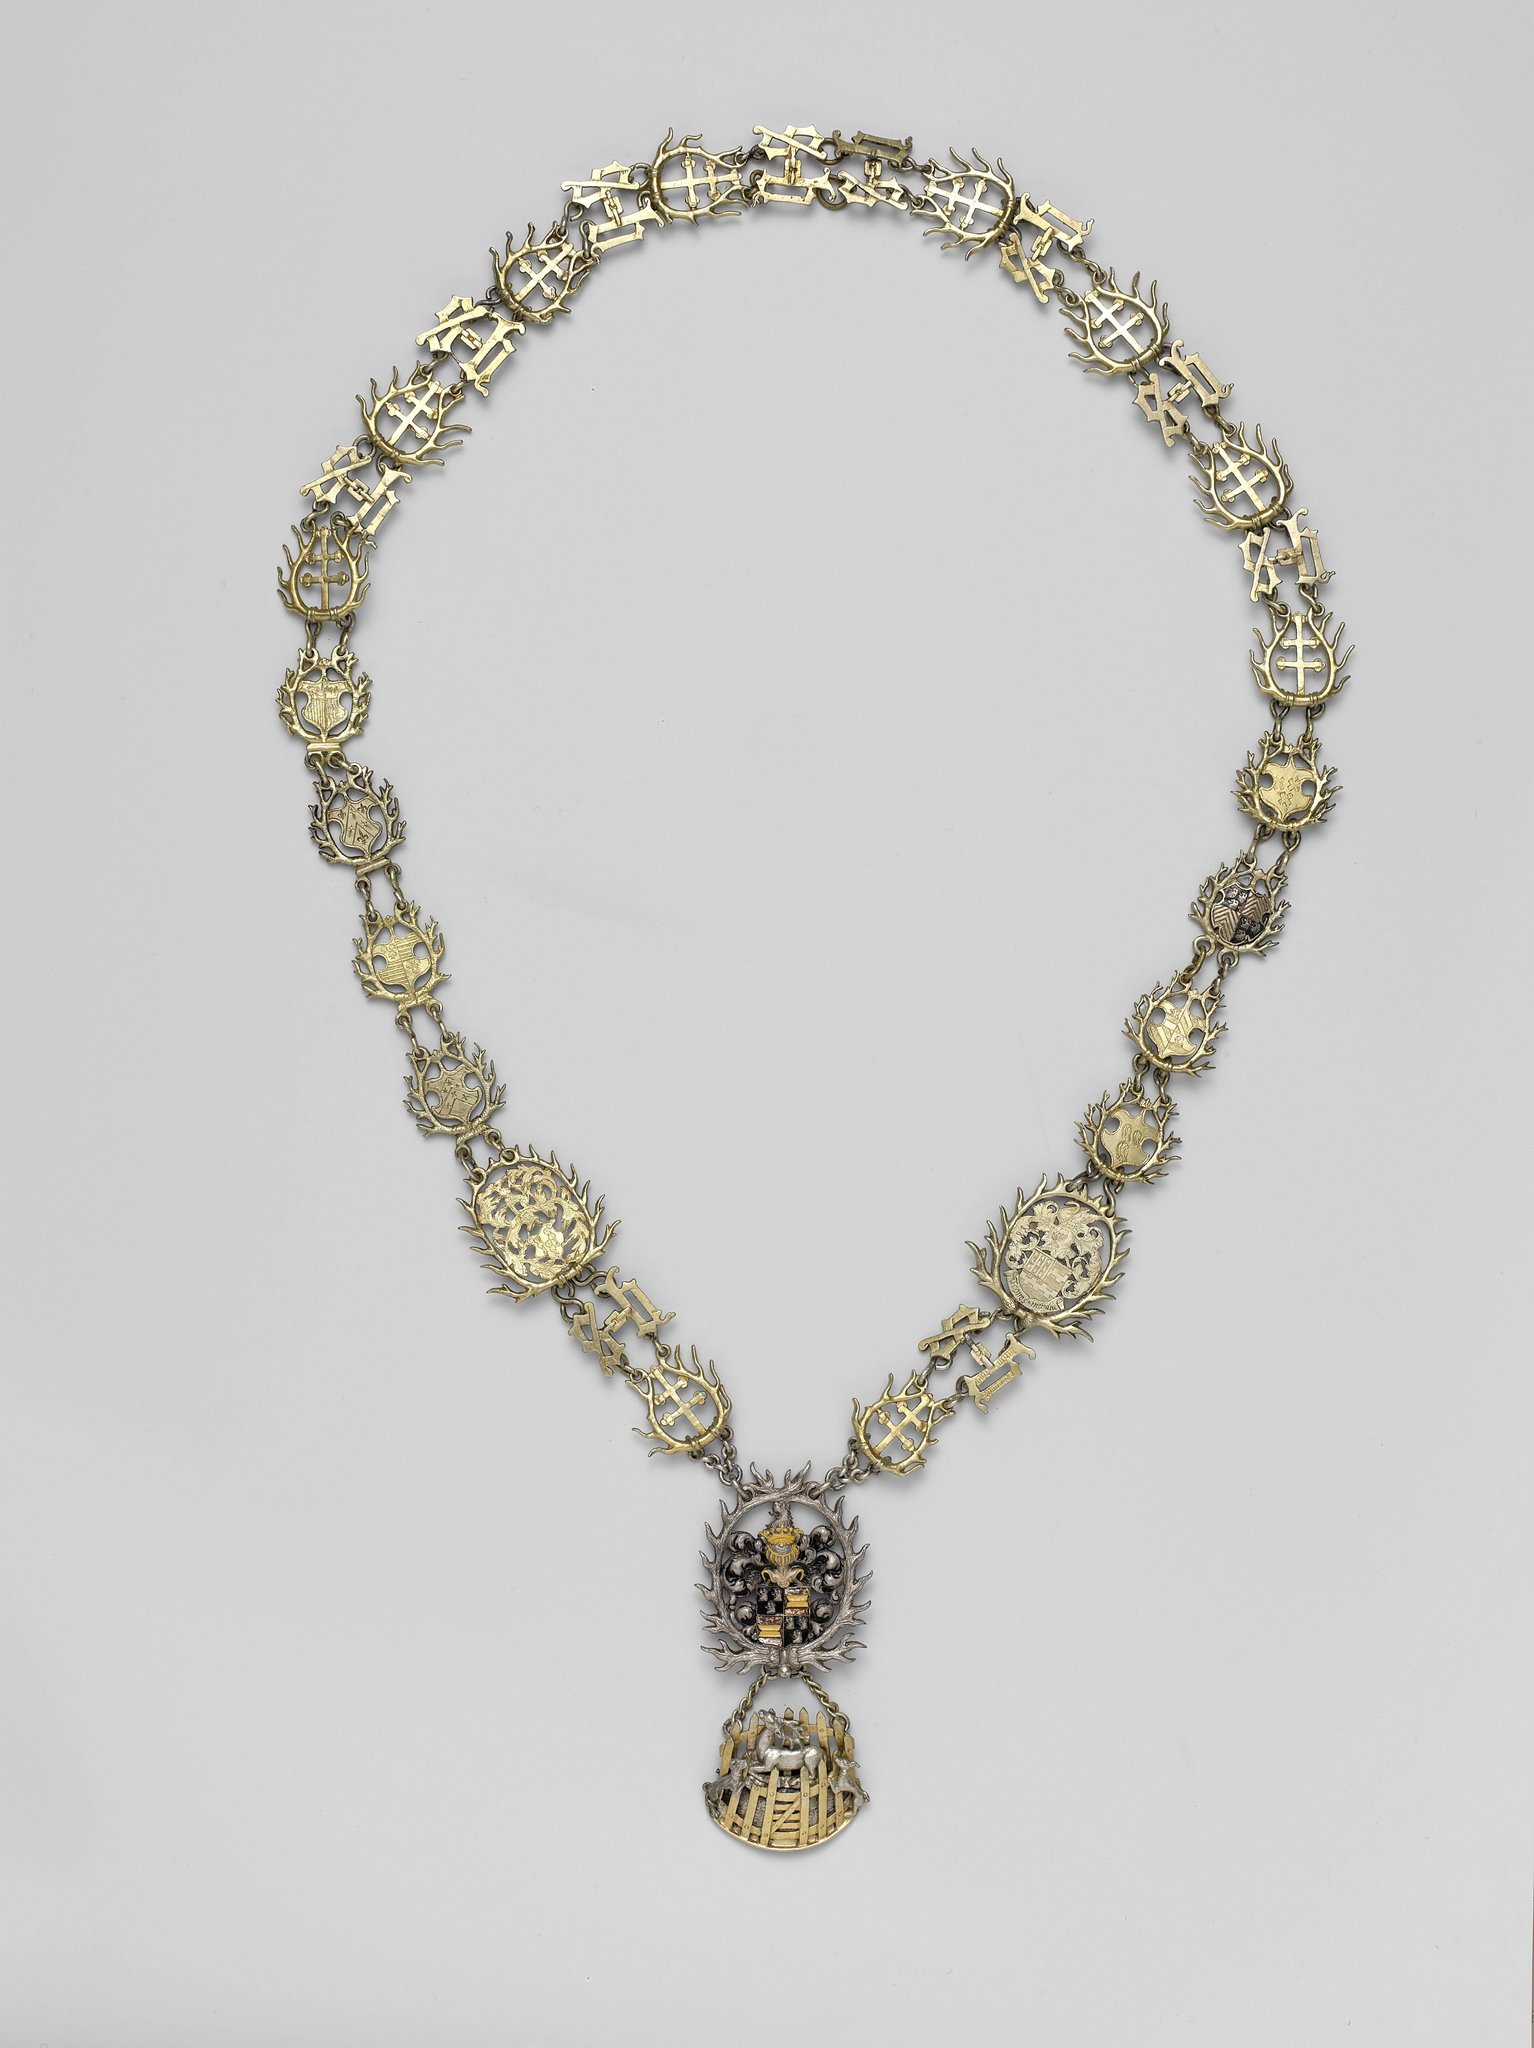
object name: schuttersketen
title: Chain of the Guild of Saint Hubert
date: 1542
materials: silver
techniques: engraving, gilding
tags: hoofed animals: deer, armorial bearing, heraldry, the hague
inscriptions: inscription: ‘PIRNEYS JACOB ZOE’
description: Between the links of this chain, one sees the letters S and H with an antler and a double cross. With the pendant at the bottom, these refer to Saint Hubert, patron saint of militia companies. The links with arms are those of the governors of the Guild of Saint Hubert, established in The Hague in 1542; these were added later.